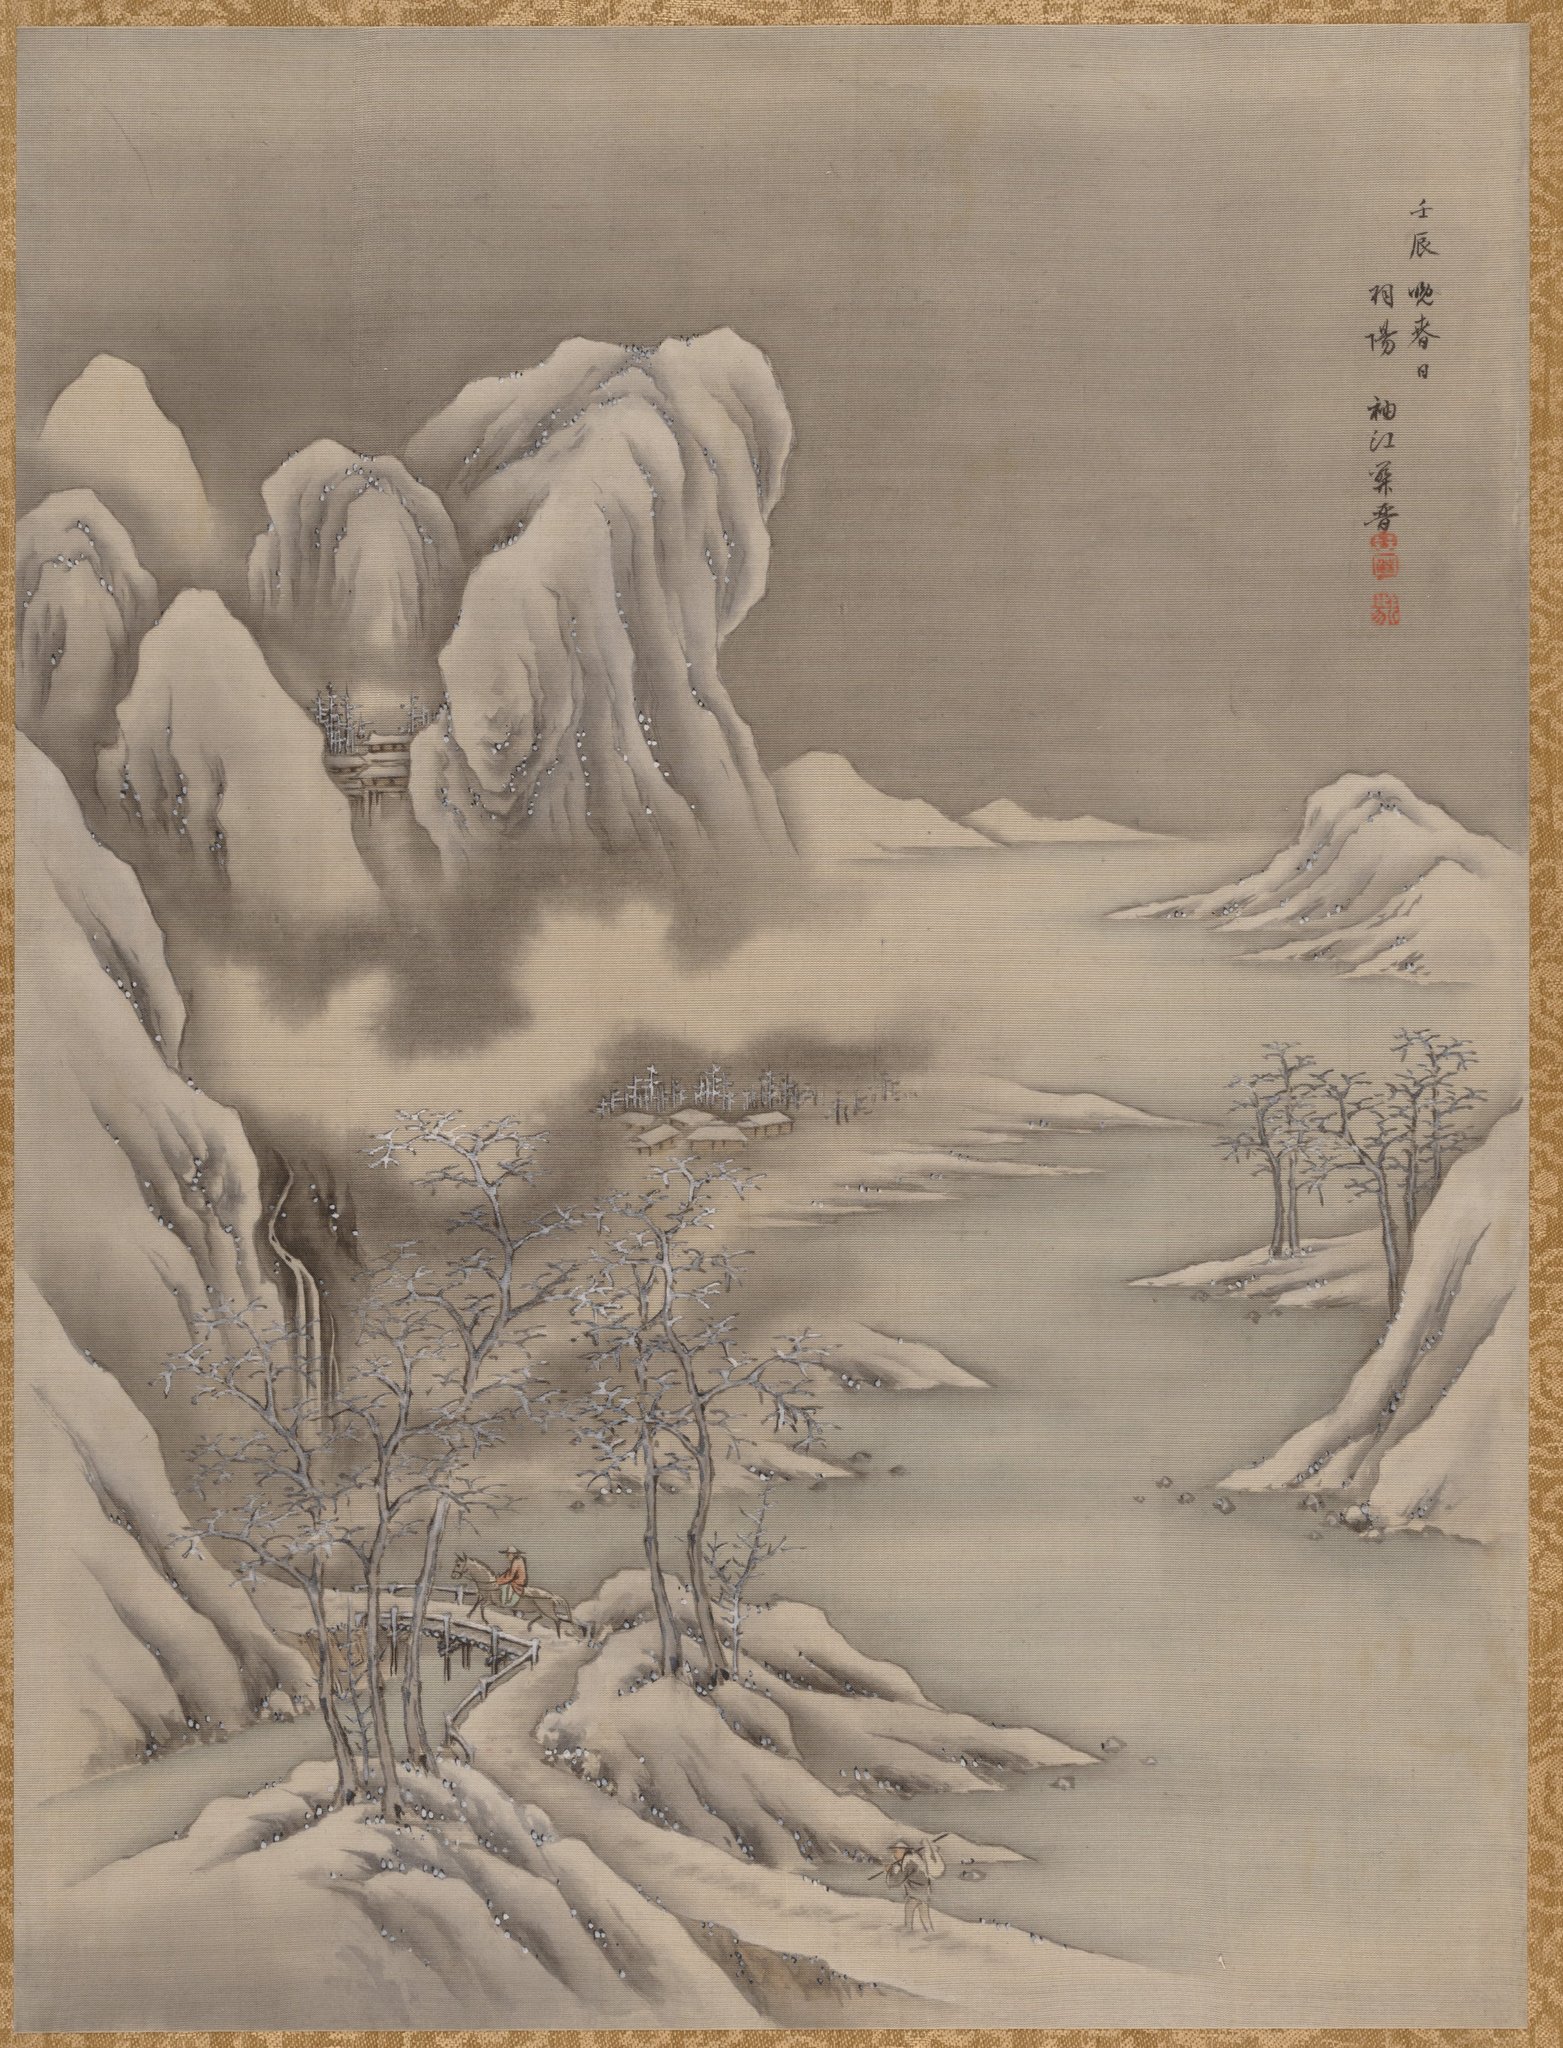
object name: album leaf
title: Winter Scene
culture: japanese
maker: seki shūkō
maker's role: artist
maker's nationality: japanese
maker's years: 1858-1915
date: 1892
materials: silk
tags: landscapes,winter,snow